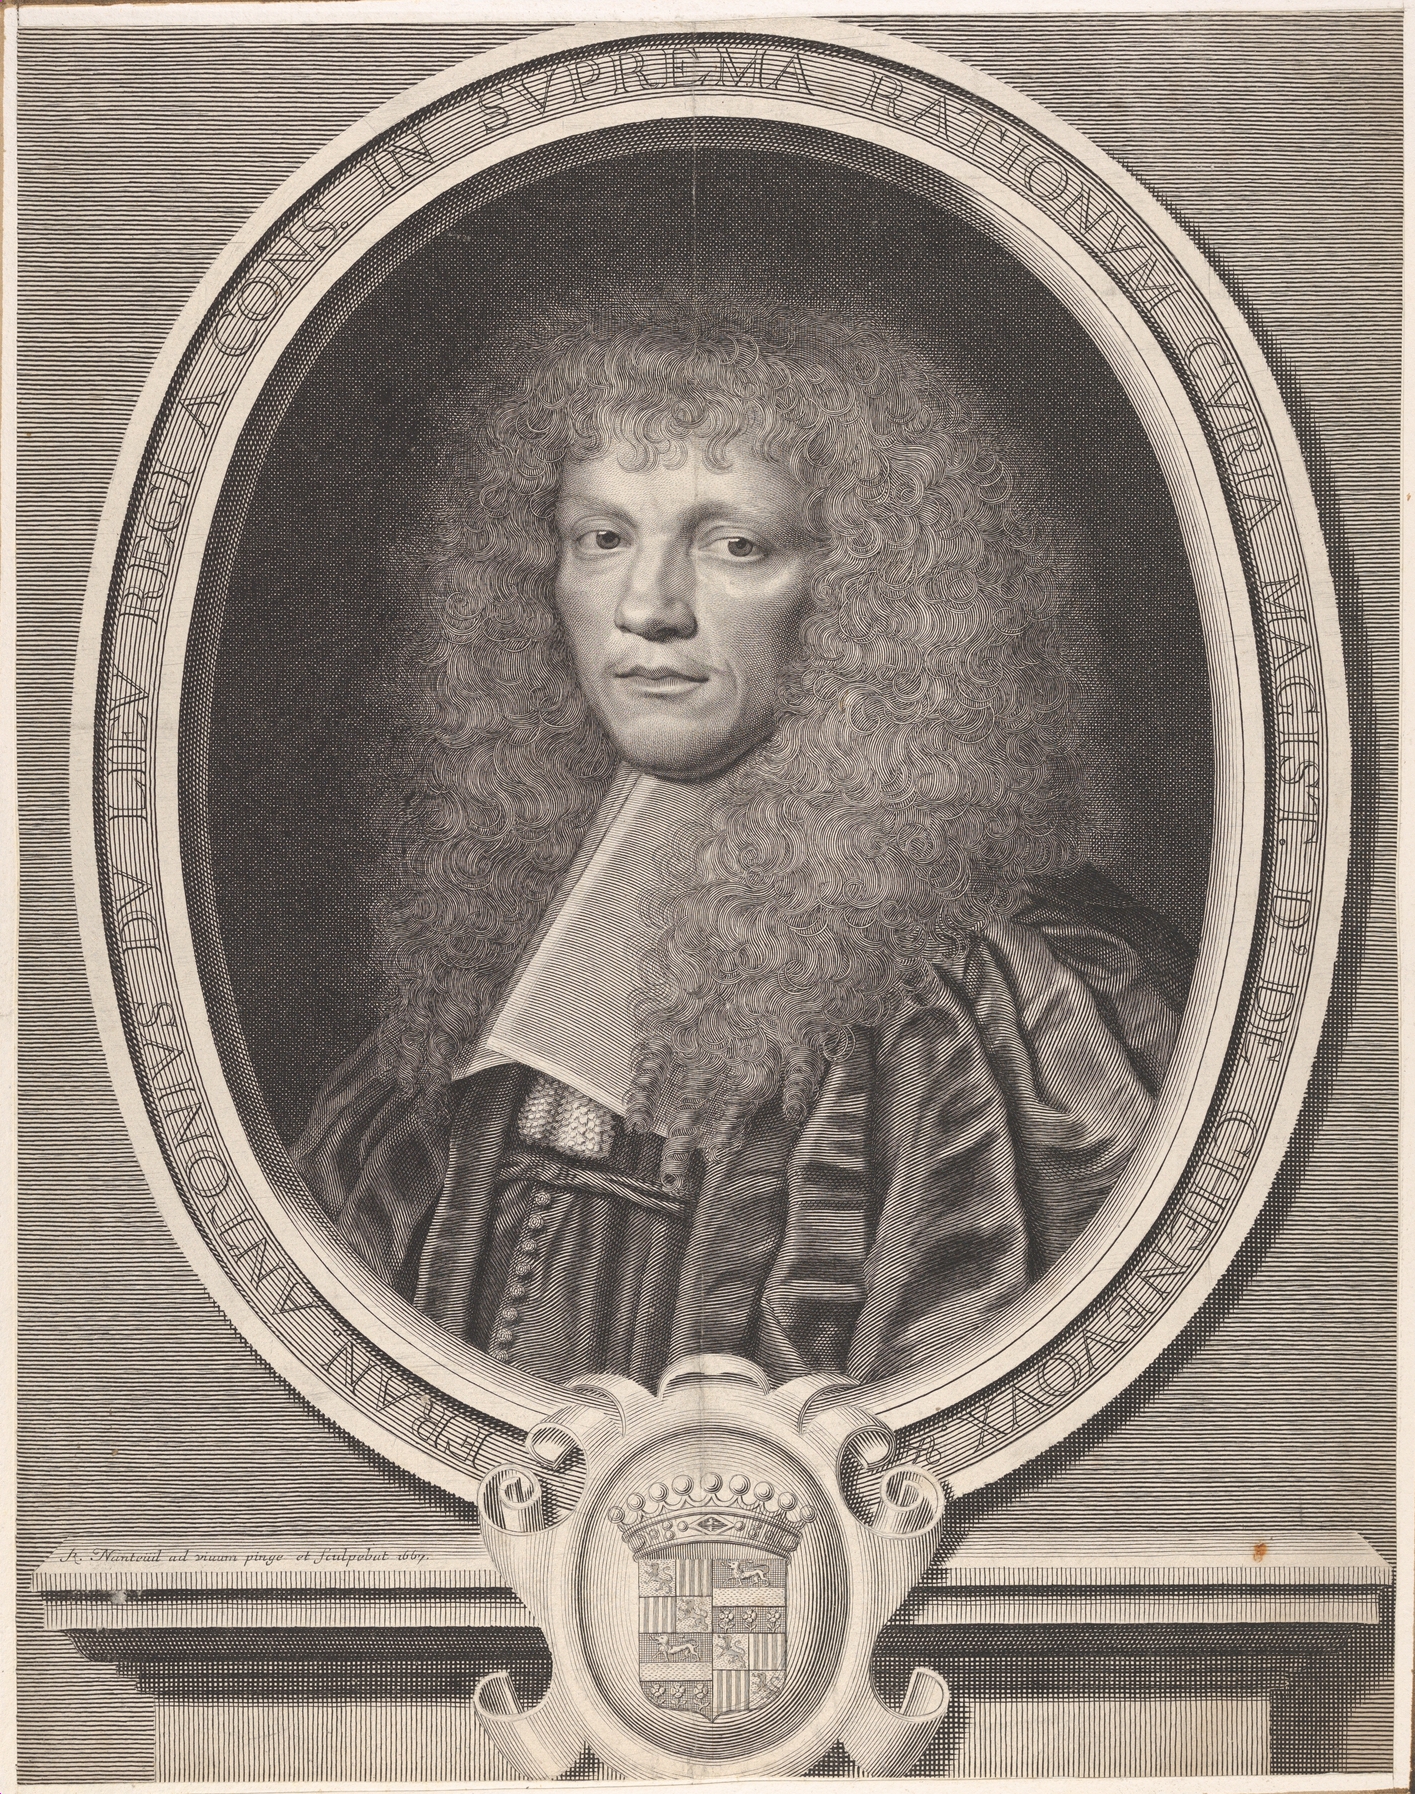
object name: print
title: François-Antoine Dulieu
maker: robert nanteuil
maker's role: artist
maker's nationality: french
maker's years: 1623-1678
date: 1667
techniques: engraving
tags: men,portraits,coat of arms